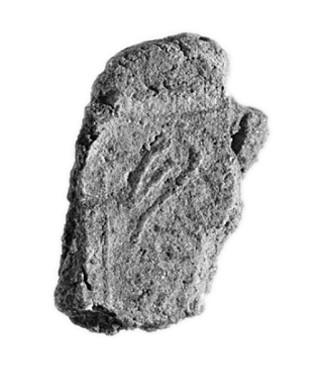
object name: sealing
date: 1981-1640 BCE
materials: mud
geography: egypt